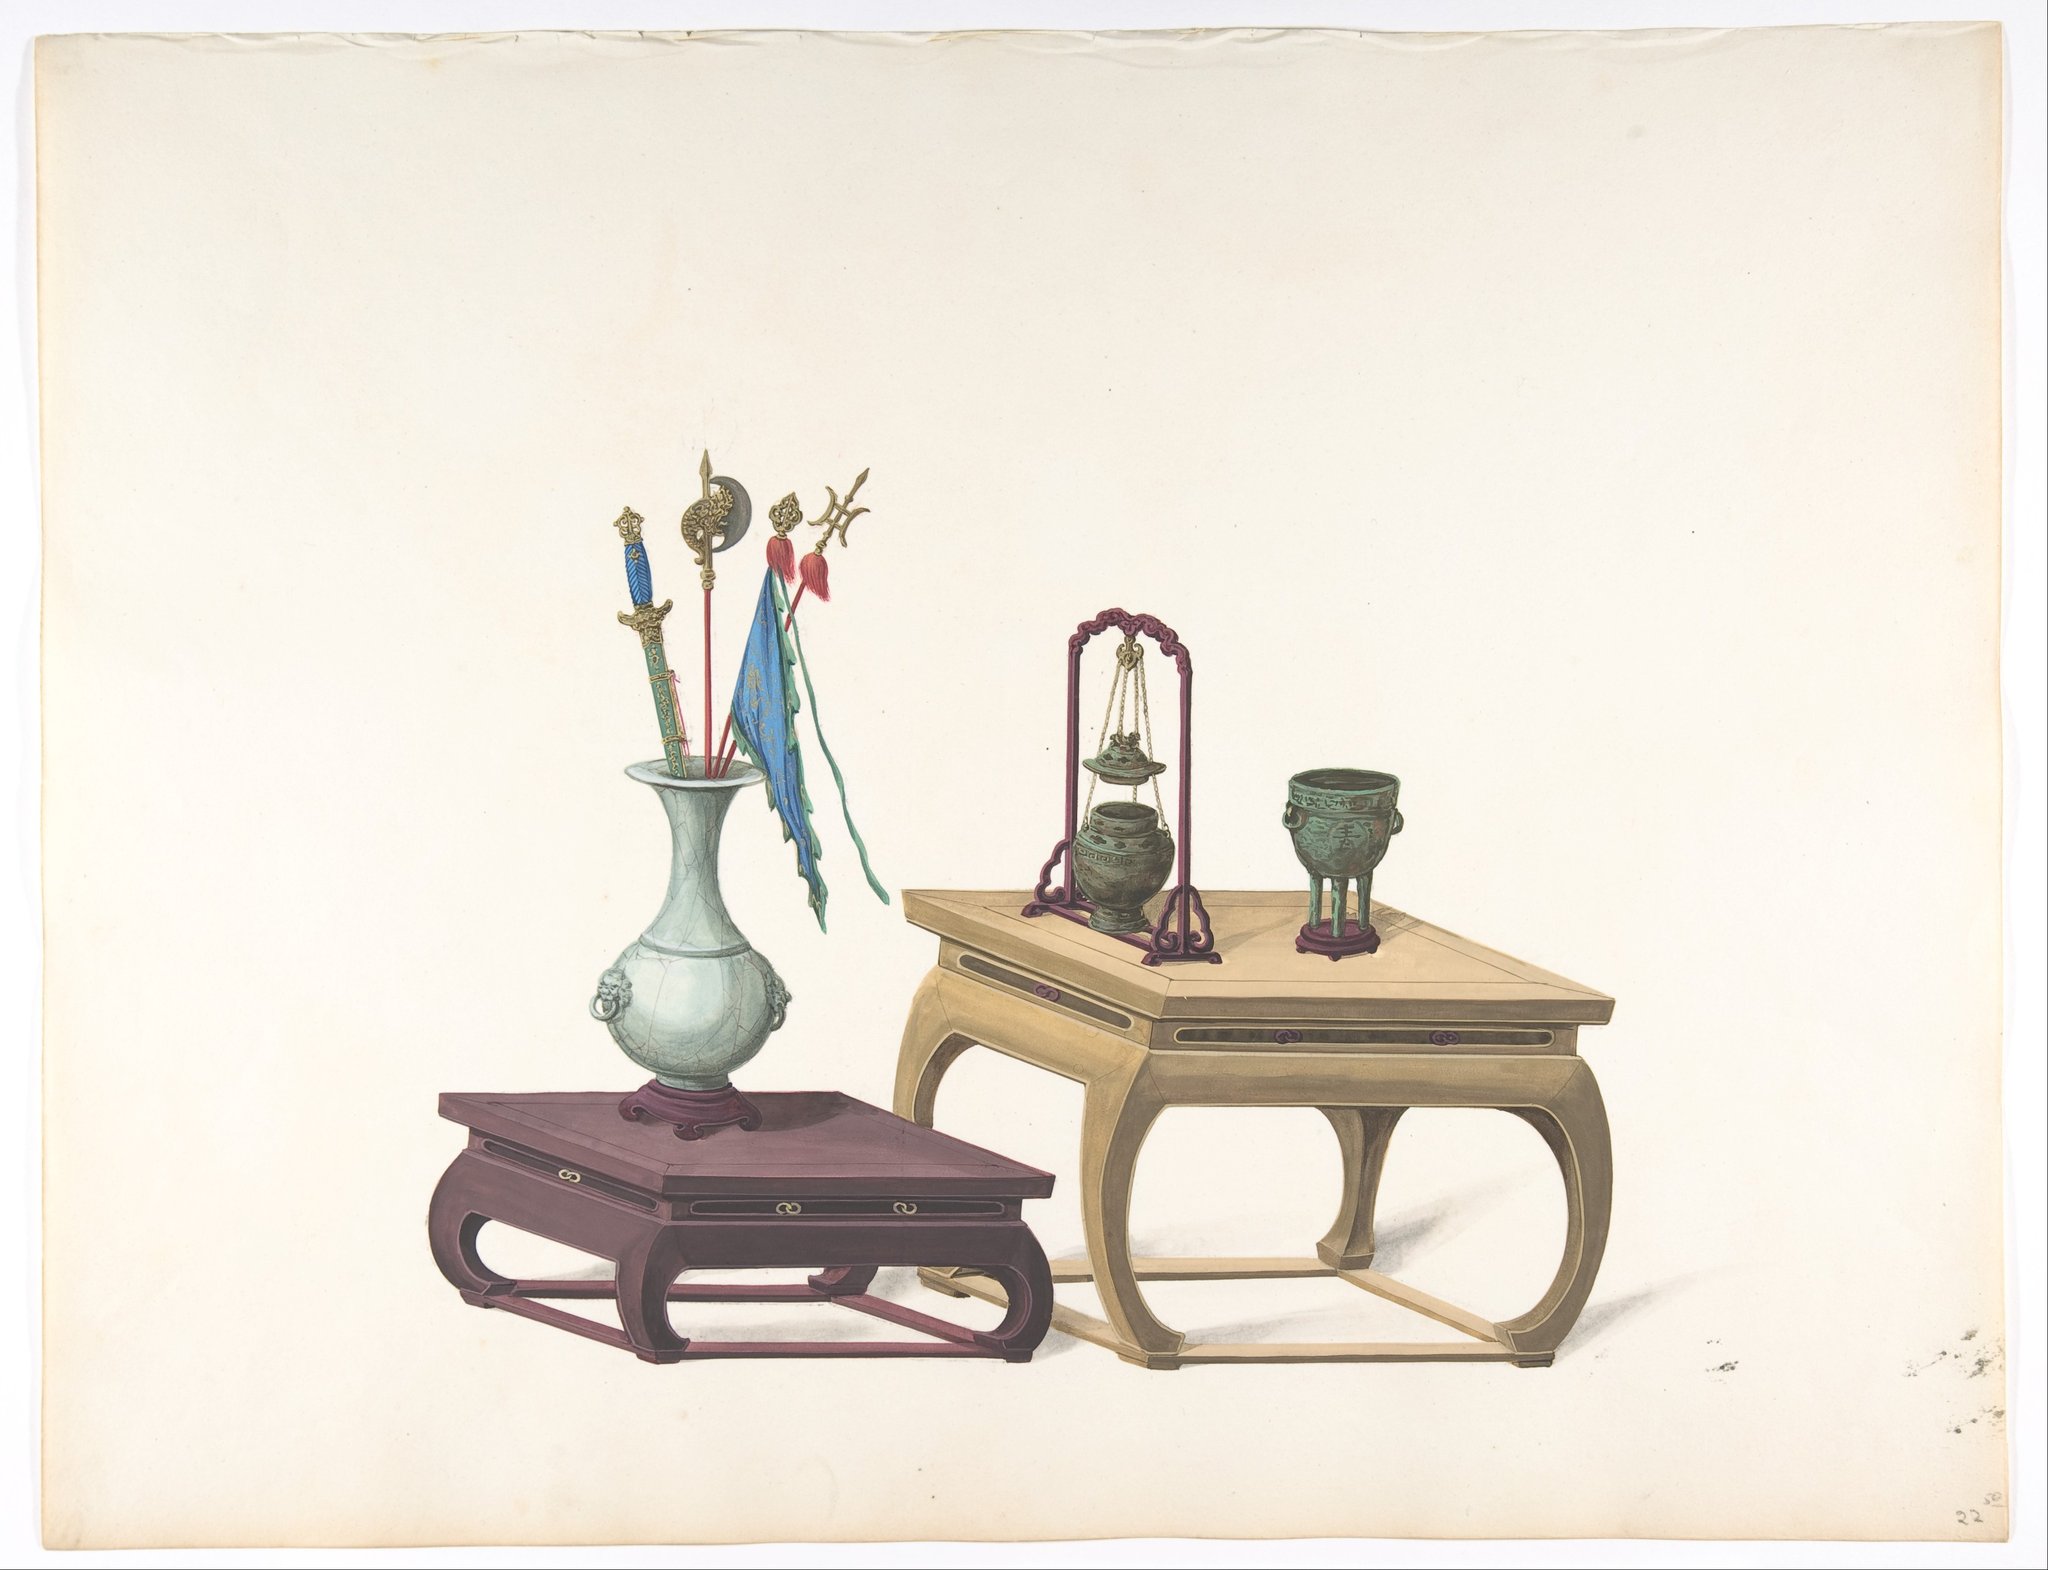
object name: drawing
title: Two Low Tables with Ornamental Objects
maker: anonymous, chinese, 19th century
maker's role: artist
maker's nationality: chinese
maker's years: 1800-1900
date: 1801-1900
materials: gouache, ink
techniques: pen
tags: tables